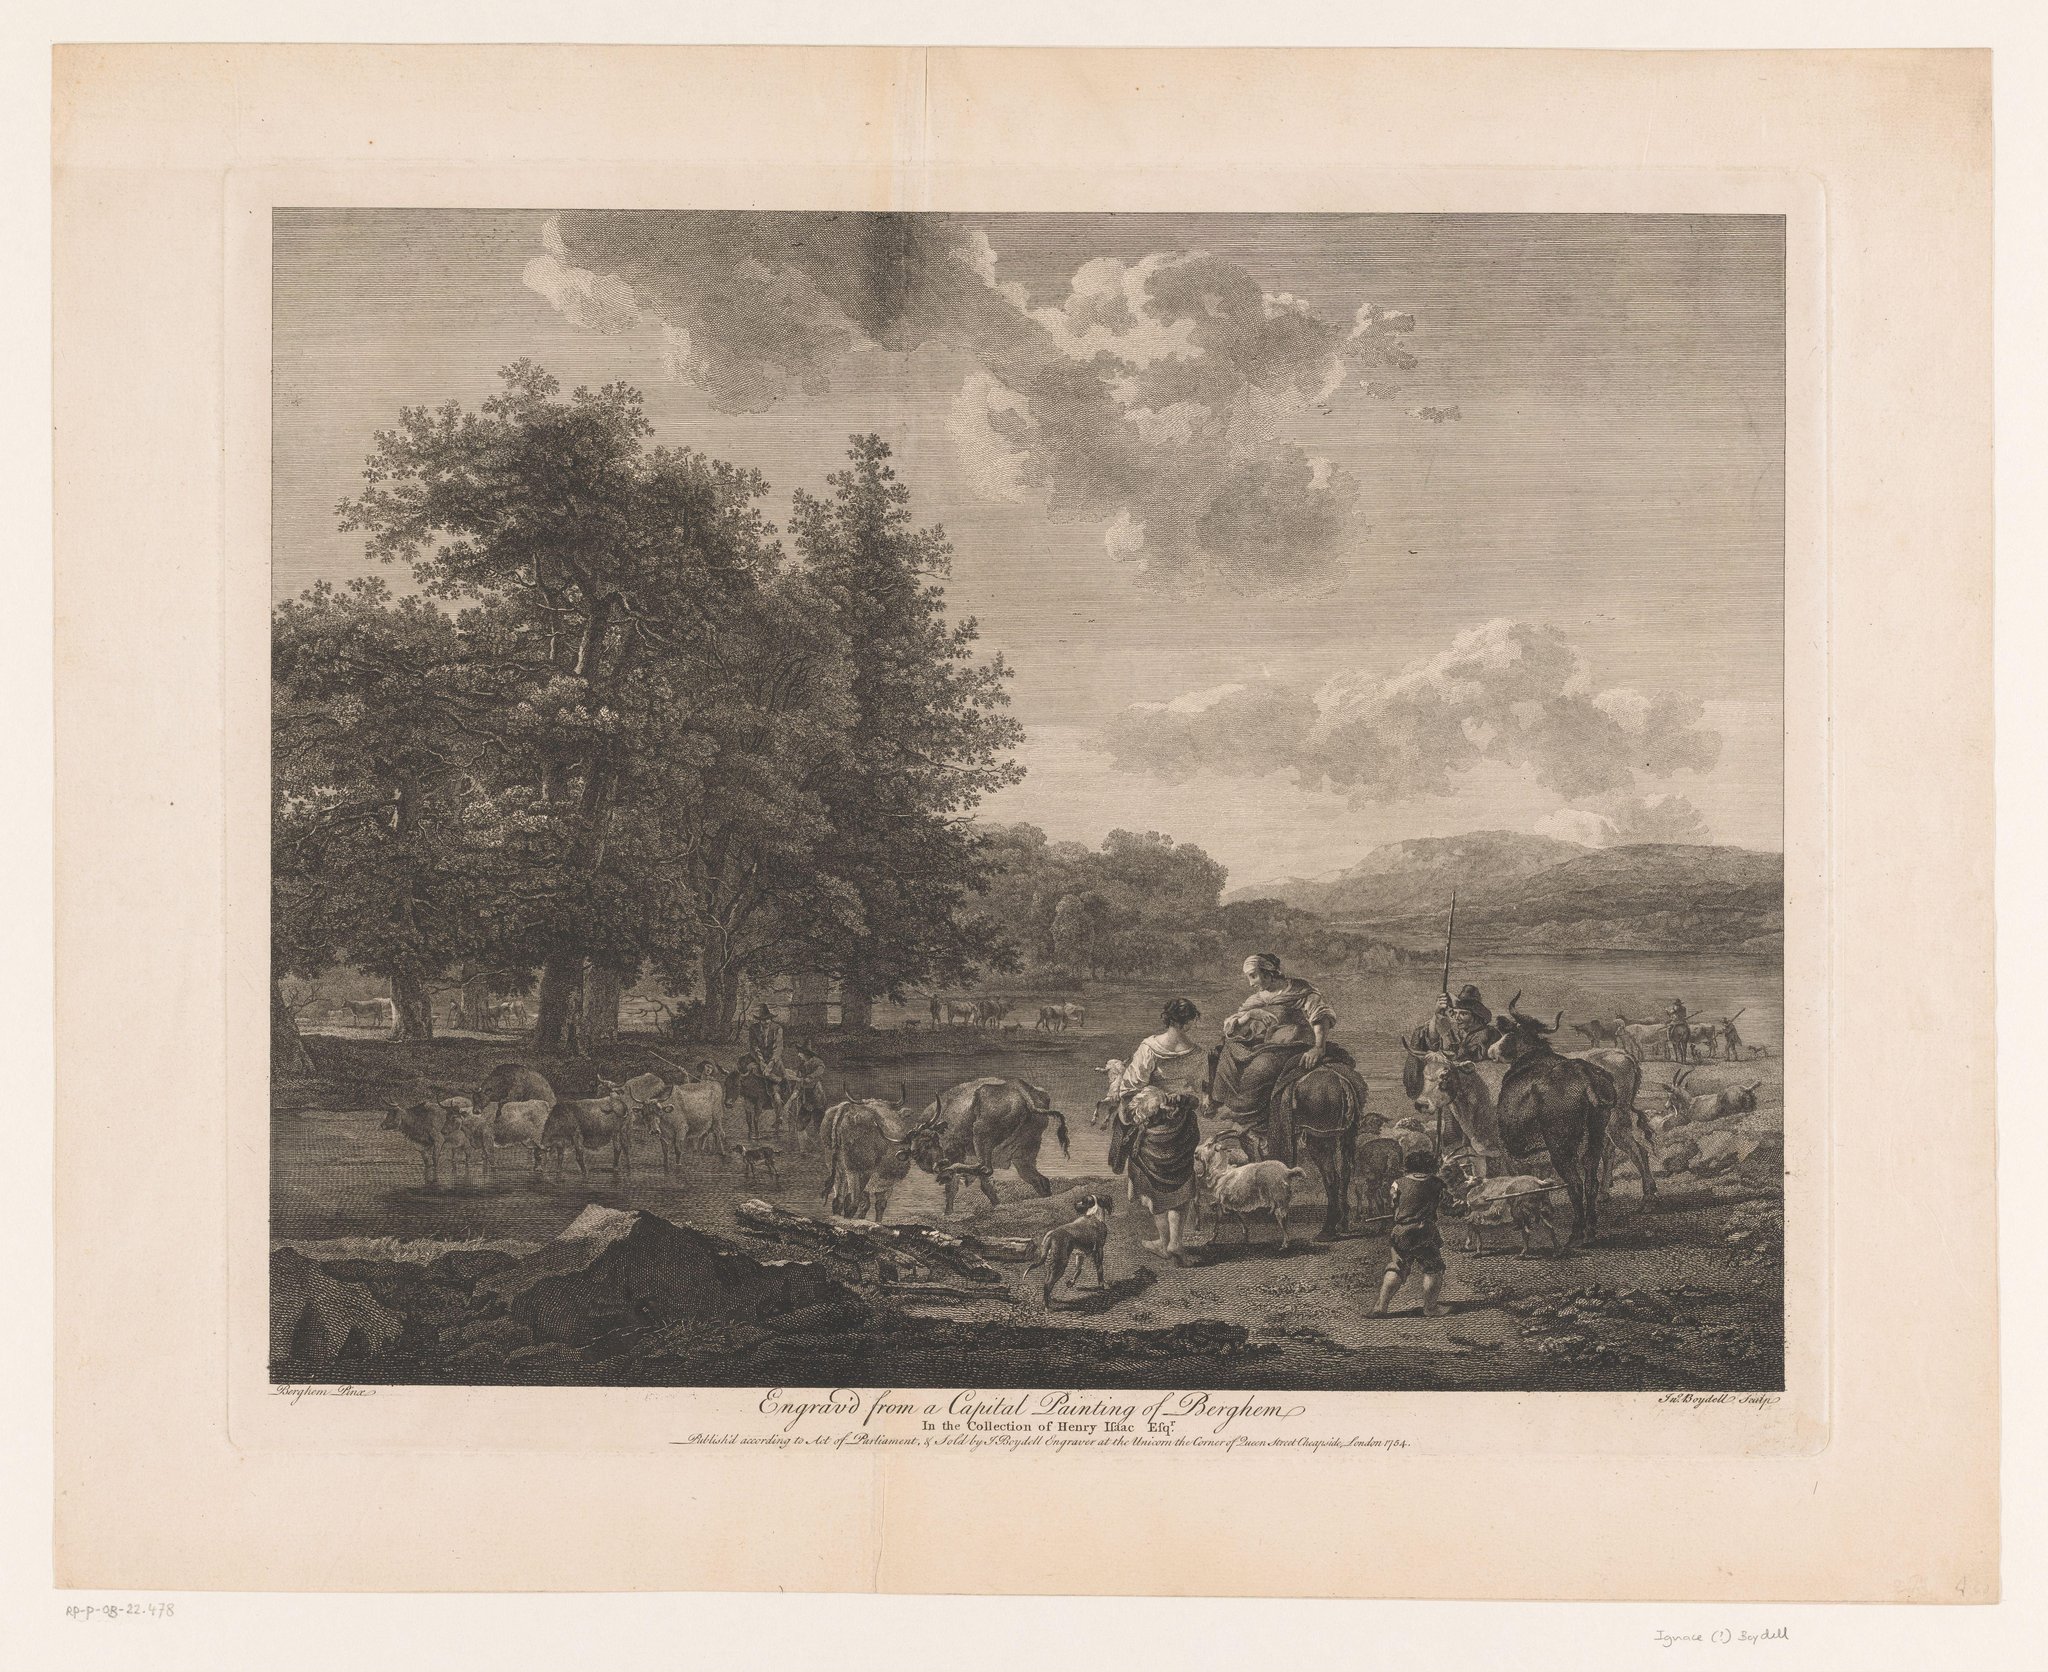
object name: print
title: Landschap met herders en vee bij een rivier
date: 1754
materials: paper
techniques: etching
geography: london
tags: herding, herdsman, herdswoman, shepherd, shepherdess, cowherd, etc., cattle, river (+ landscape with figures, staffage), (high) hill (+ landscape with figures, staffage)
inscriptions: collector's mark: Lugt 240